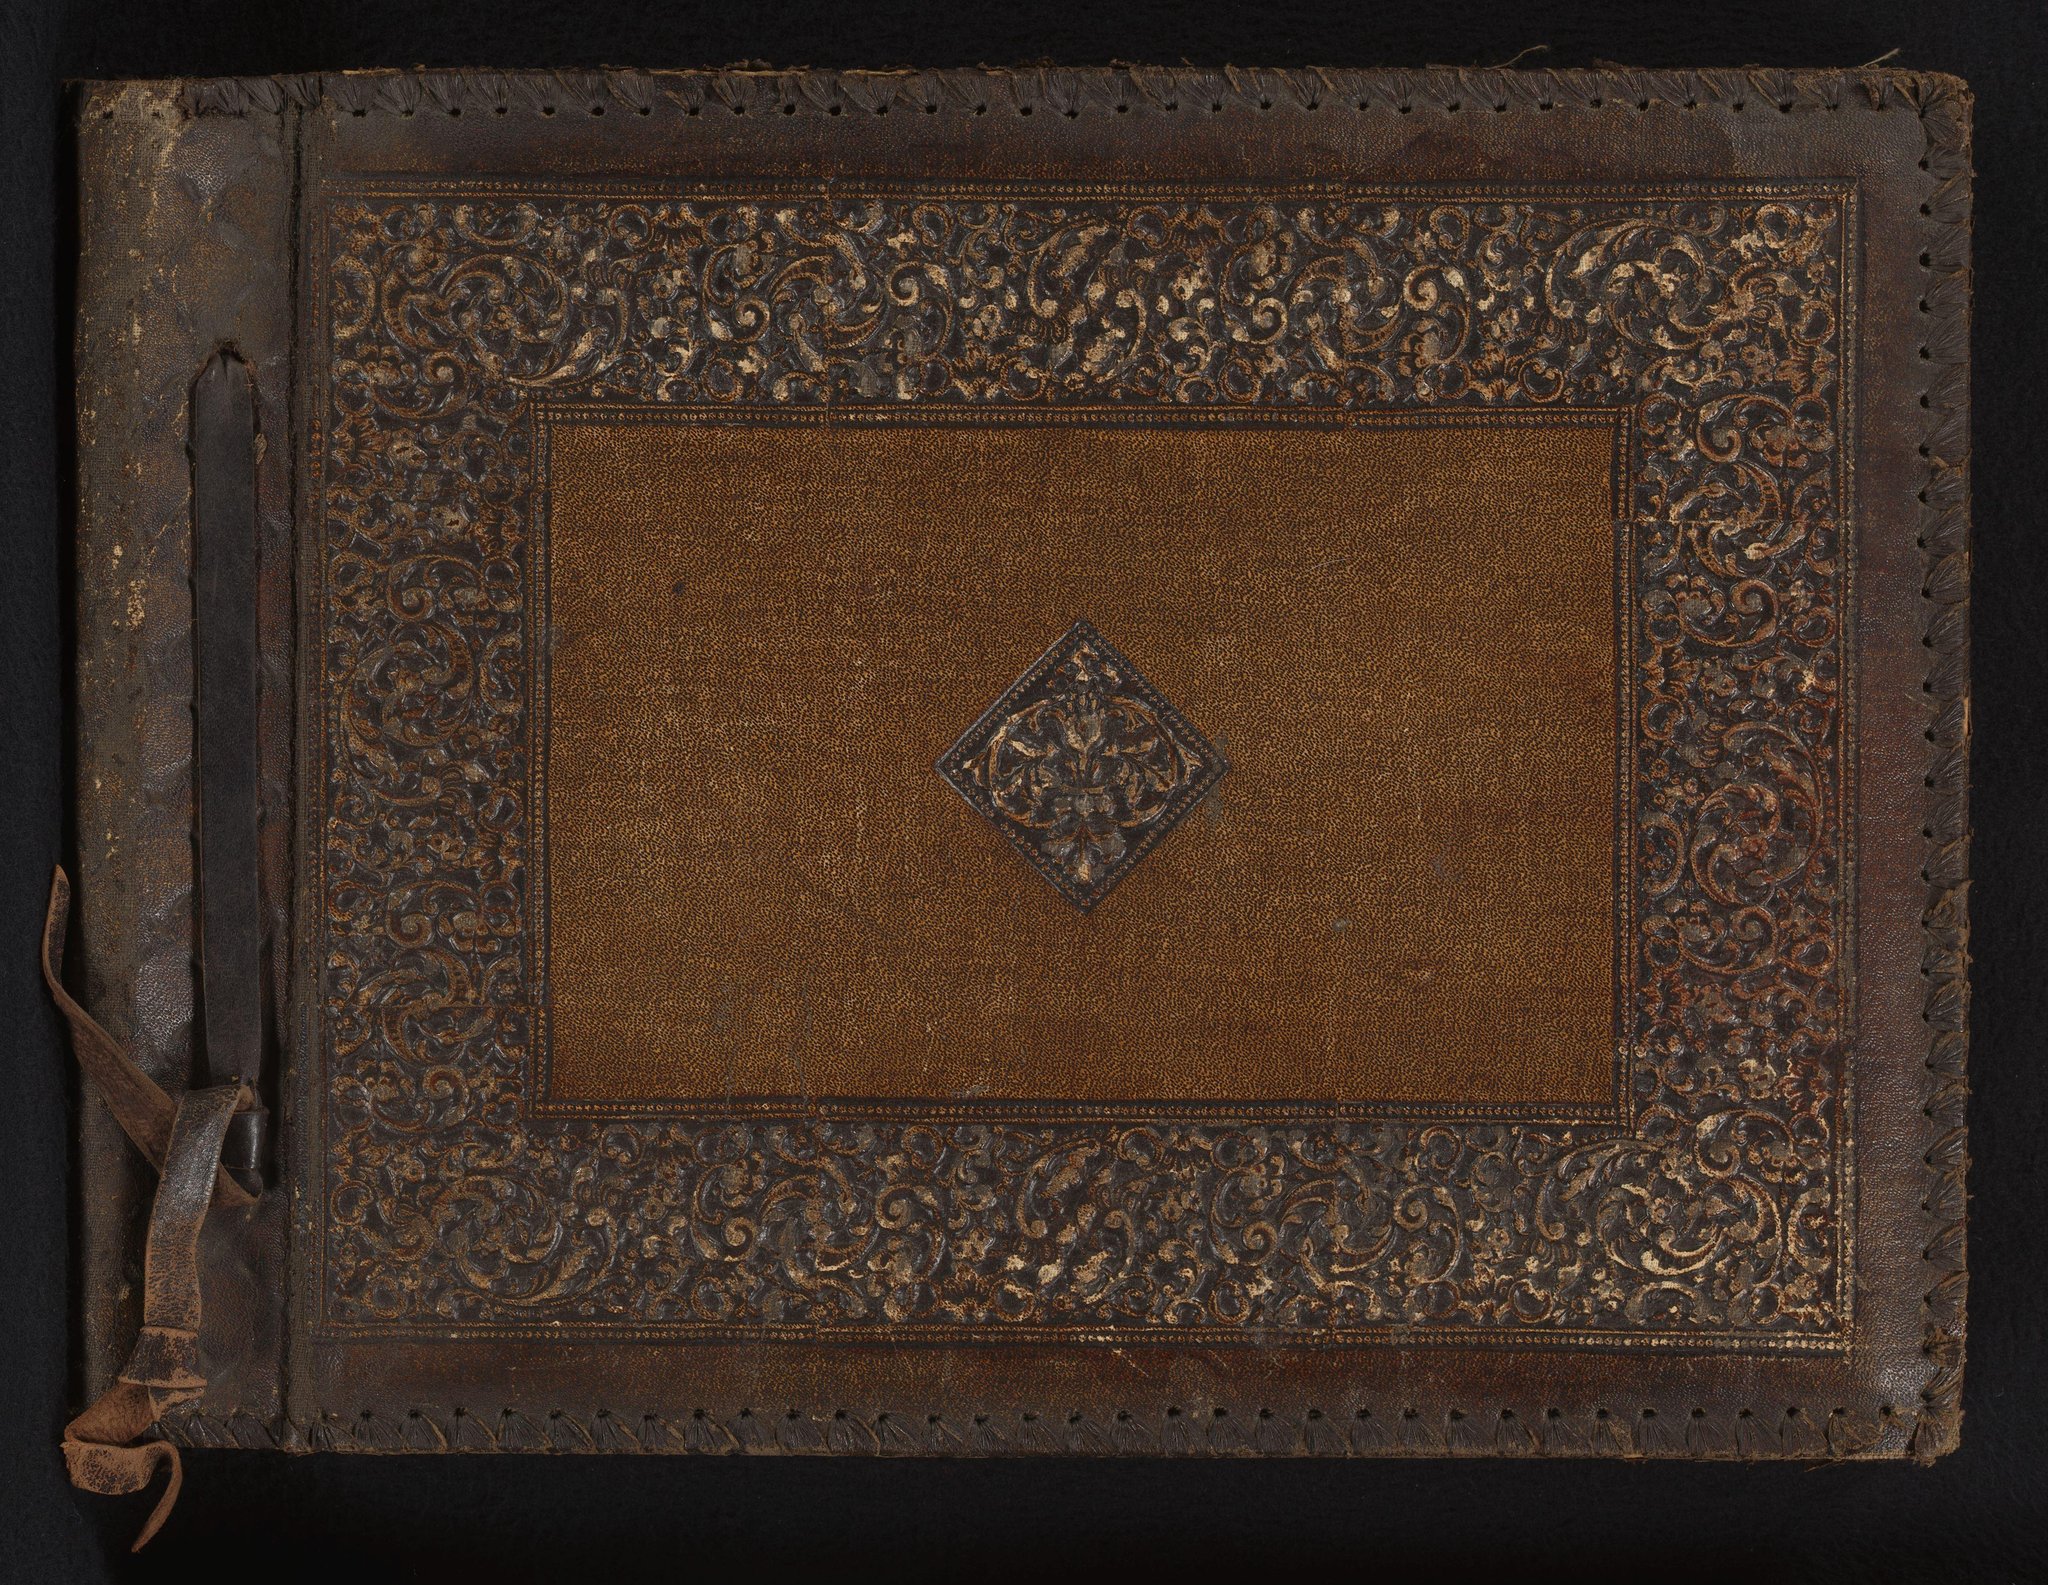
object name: scrapbook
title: Fotoalbum met 89 foto's van Juliana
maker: Anonymous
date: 1892-1936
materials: paper, cardboard, leather, silk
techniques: gelatin silver print, moire, rotogravure, writing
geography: netherlands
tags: the hague, print maker, wilhelmina of the netherlands, hendrik (prins der nederlanden (1876-1934)), emma (queen consort of the netherlands), juliana of the netherlands, family of a ruler, and court - bb - female ruler, queen, princess, delft, royal palace of amsterdam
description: Fotoalbum met 89 foto's verdeeld over 40 pagina's. De laatste drie foto's zijn op de binnenzijde van het achterplat geplakt. De foto's, deels in de vorm van prentbriefkaarten, betreffen de eerste 27 jaar van het leven van prinses Juliana. Het album bevat tevens een programma van de onthullingsplechtigheid van een monument. De eerste vijf pagina's hebben handgeschreven bijschriften, de rest van het album niet. Van het merendeel van de foto's is de fotograaf anoniem.